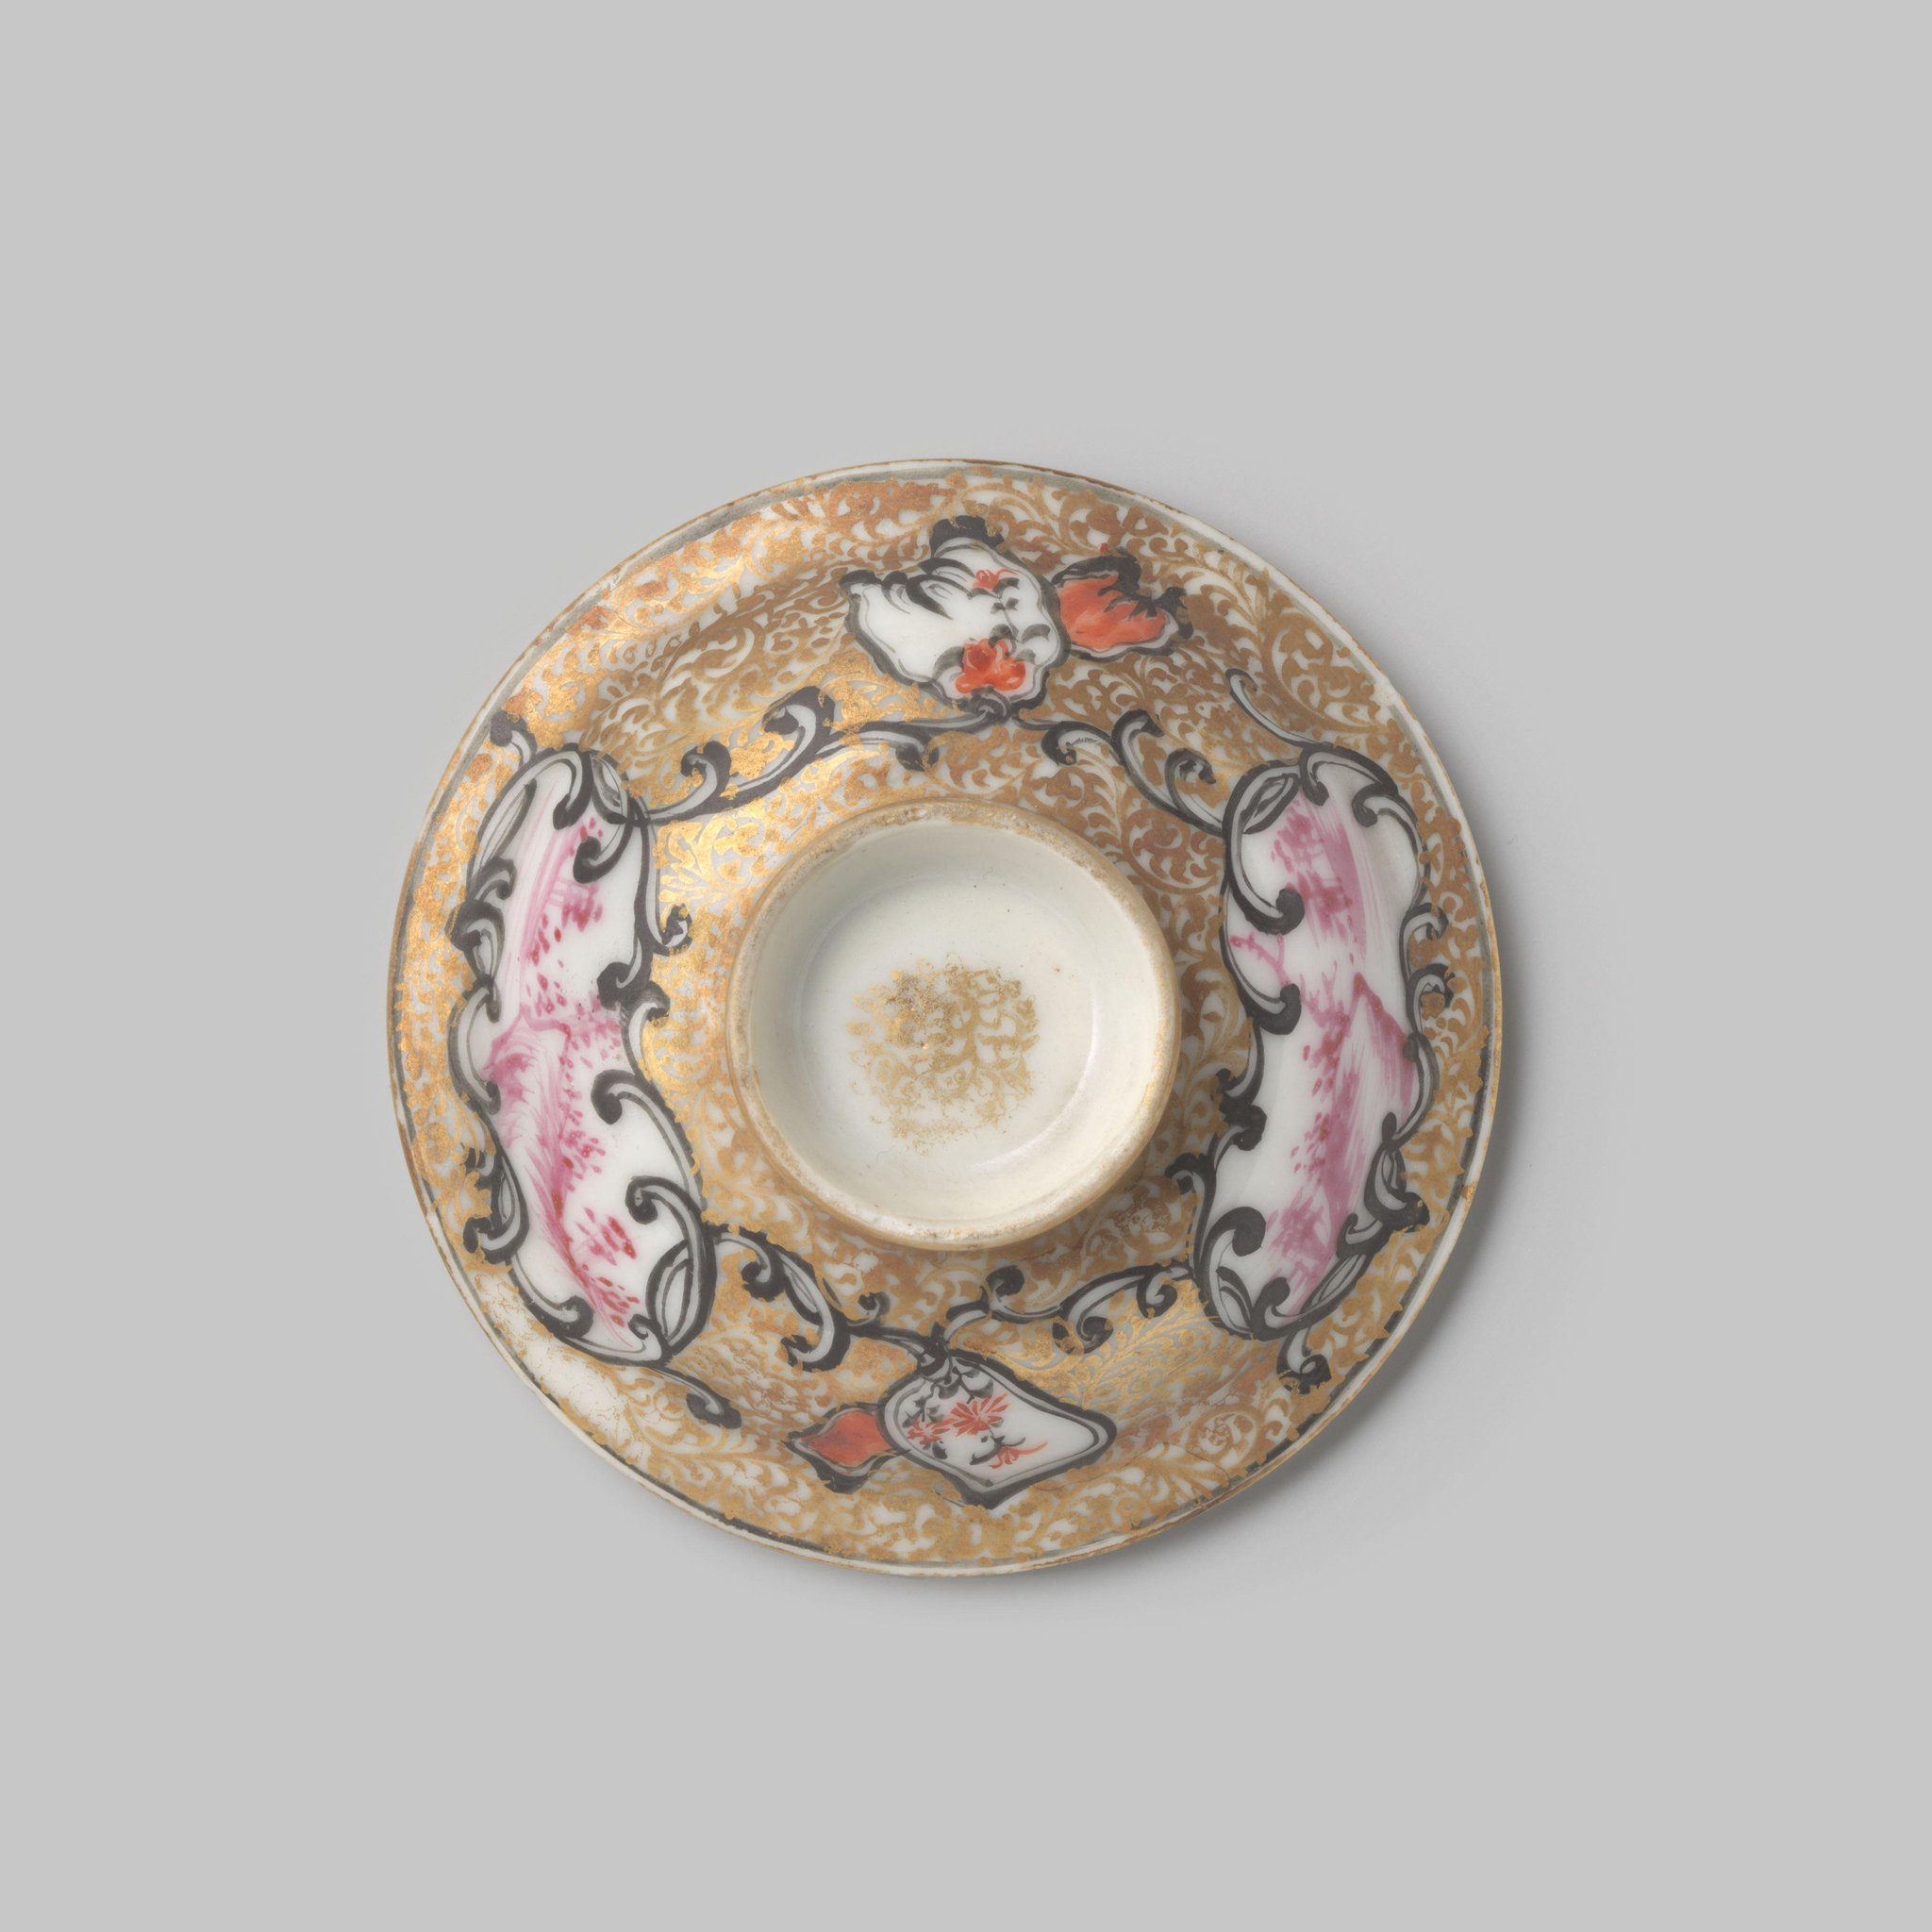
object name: kop en schotel, kop en schotel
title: Tall, covered cup with scenes and landscapes in panels on a ground of scrolls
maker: Anonymous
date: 1775-1799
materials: glaze, gold, paint, porcelain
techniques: firing, gilding, turning, vitrification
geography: china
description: Deksel van hoge dekselkop van porselein, beschilderd op het glazuur in blauw, rood, roze, geel, groen, zwart en goud. Op de wand ranken en een cartouche met twee hooggeplaatste mannen zittend aan een tafel op een terras voor een paviljoen, omringd door een derde man en twee vrouwen met een jongen afgebeeld; daaromheen verschillende cartouches met respectievelijk een bloemtak of een landschap. Famille rose/mandarijn.